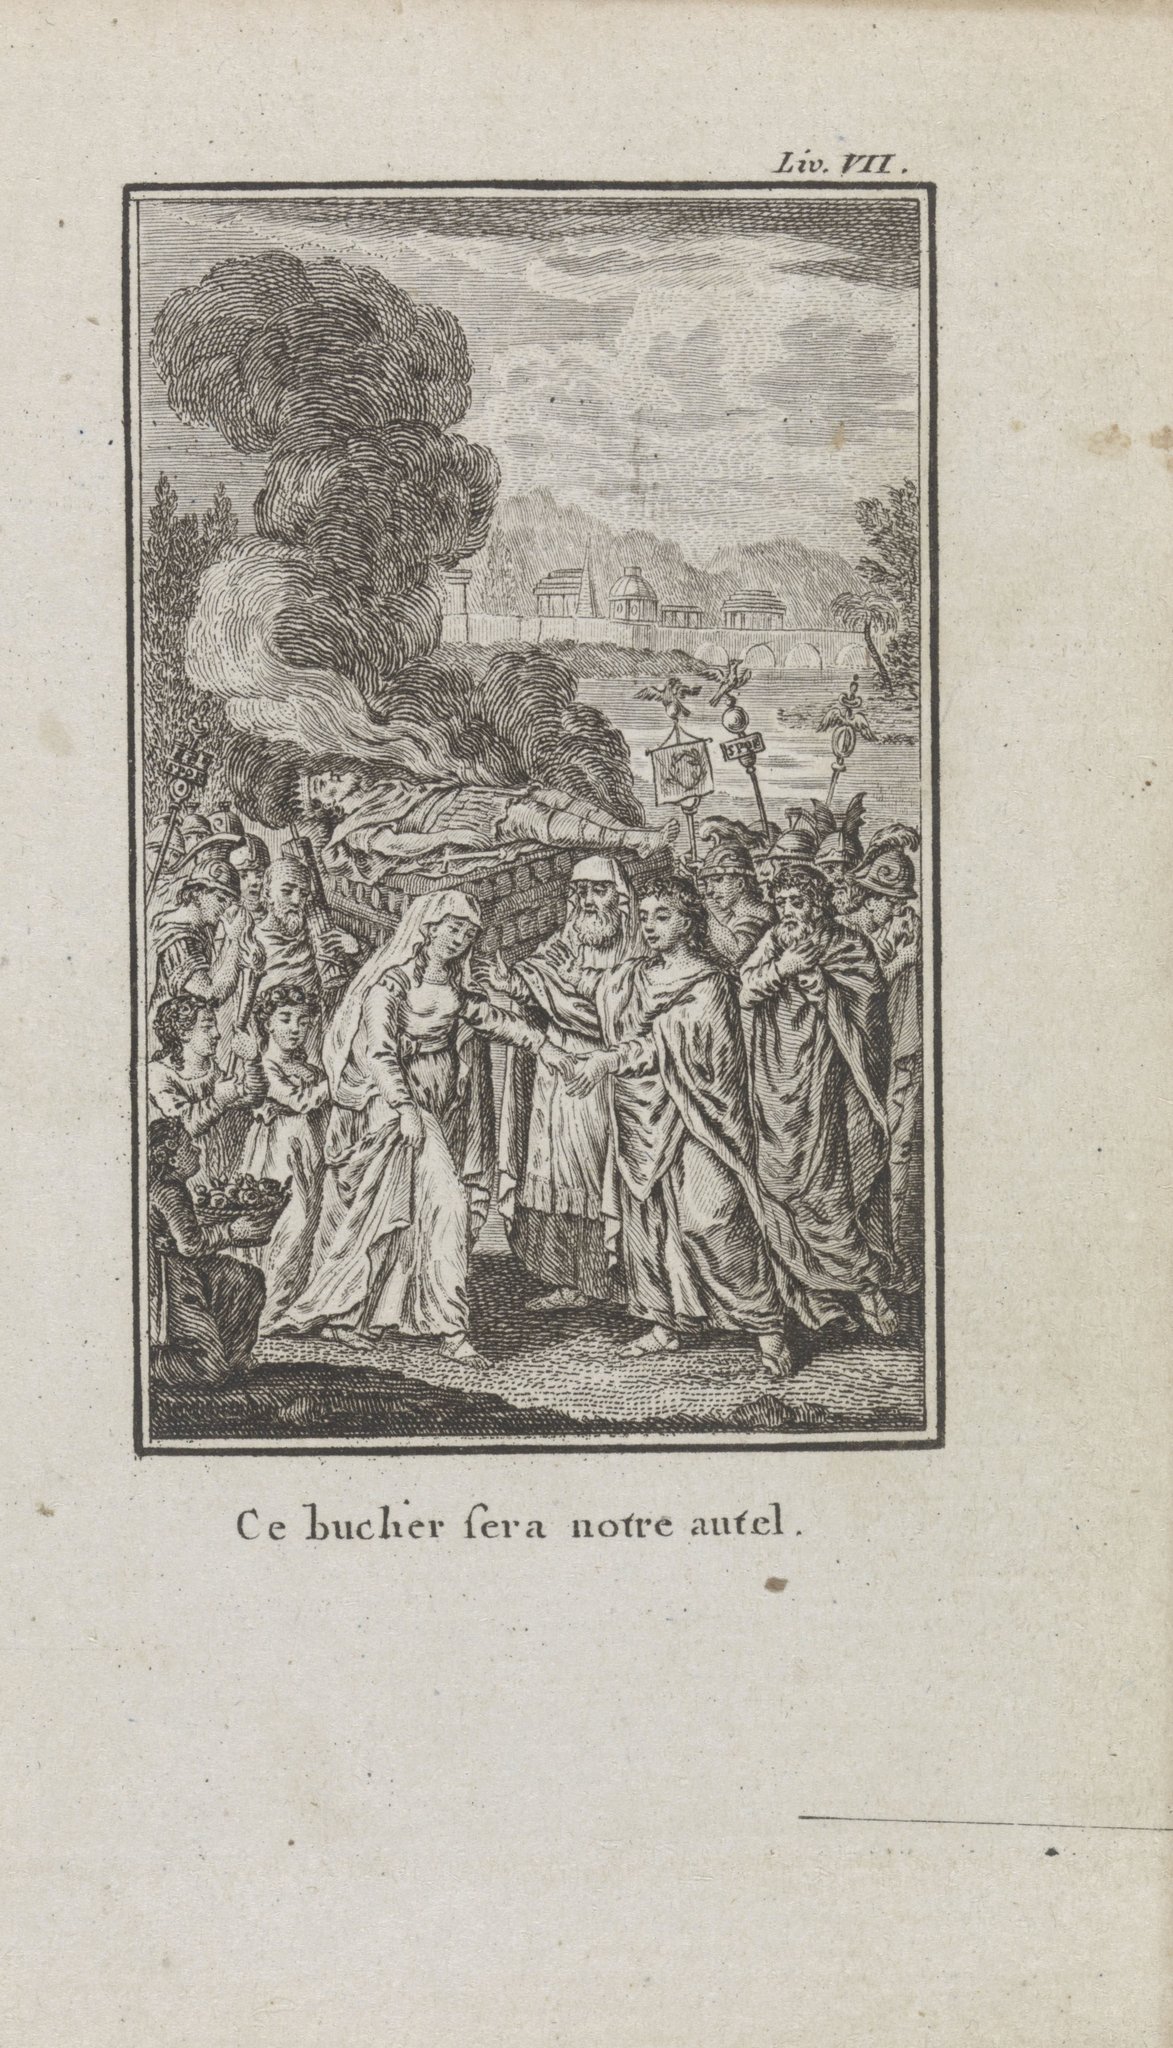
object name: print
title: Begrafenis van Tatius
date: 1790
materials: paper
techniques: engraving, letterpress printing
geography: liège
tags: body-burning, cremation, male literary characters (with name), rome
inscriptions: collector's mark: Lugt 2228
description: Titus Tatius, de koning van de Sabijnen, wordt op een brandstapel gecremeerd. Zijn troepen rouwend rondom het vuur. Numa troost zijn dochter Tatia. Op de achtergrond Rome. Met een Frans onderschrift.